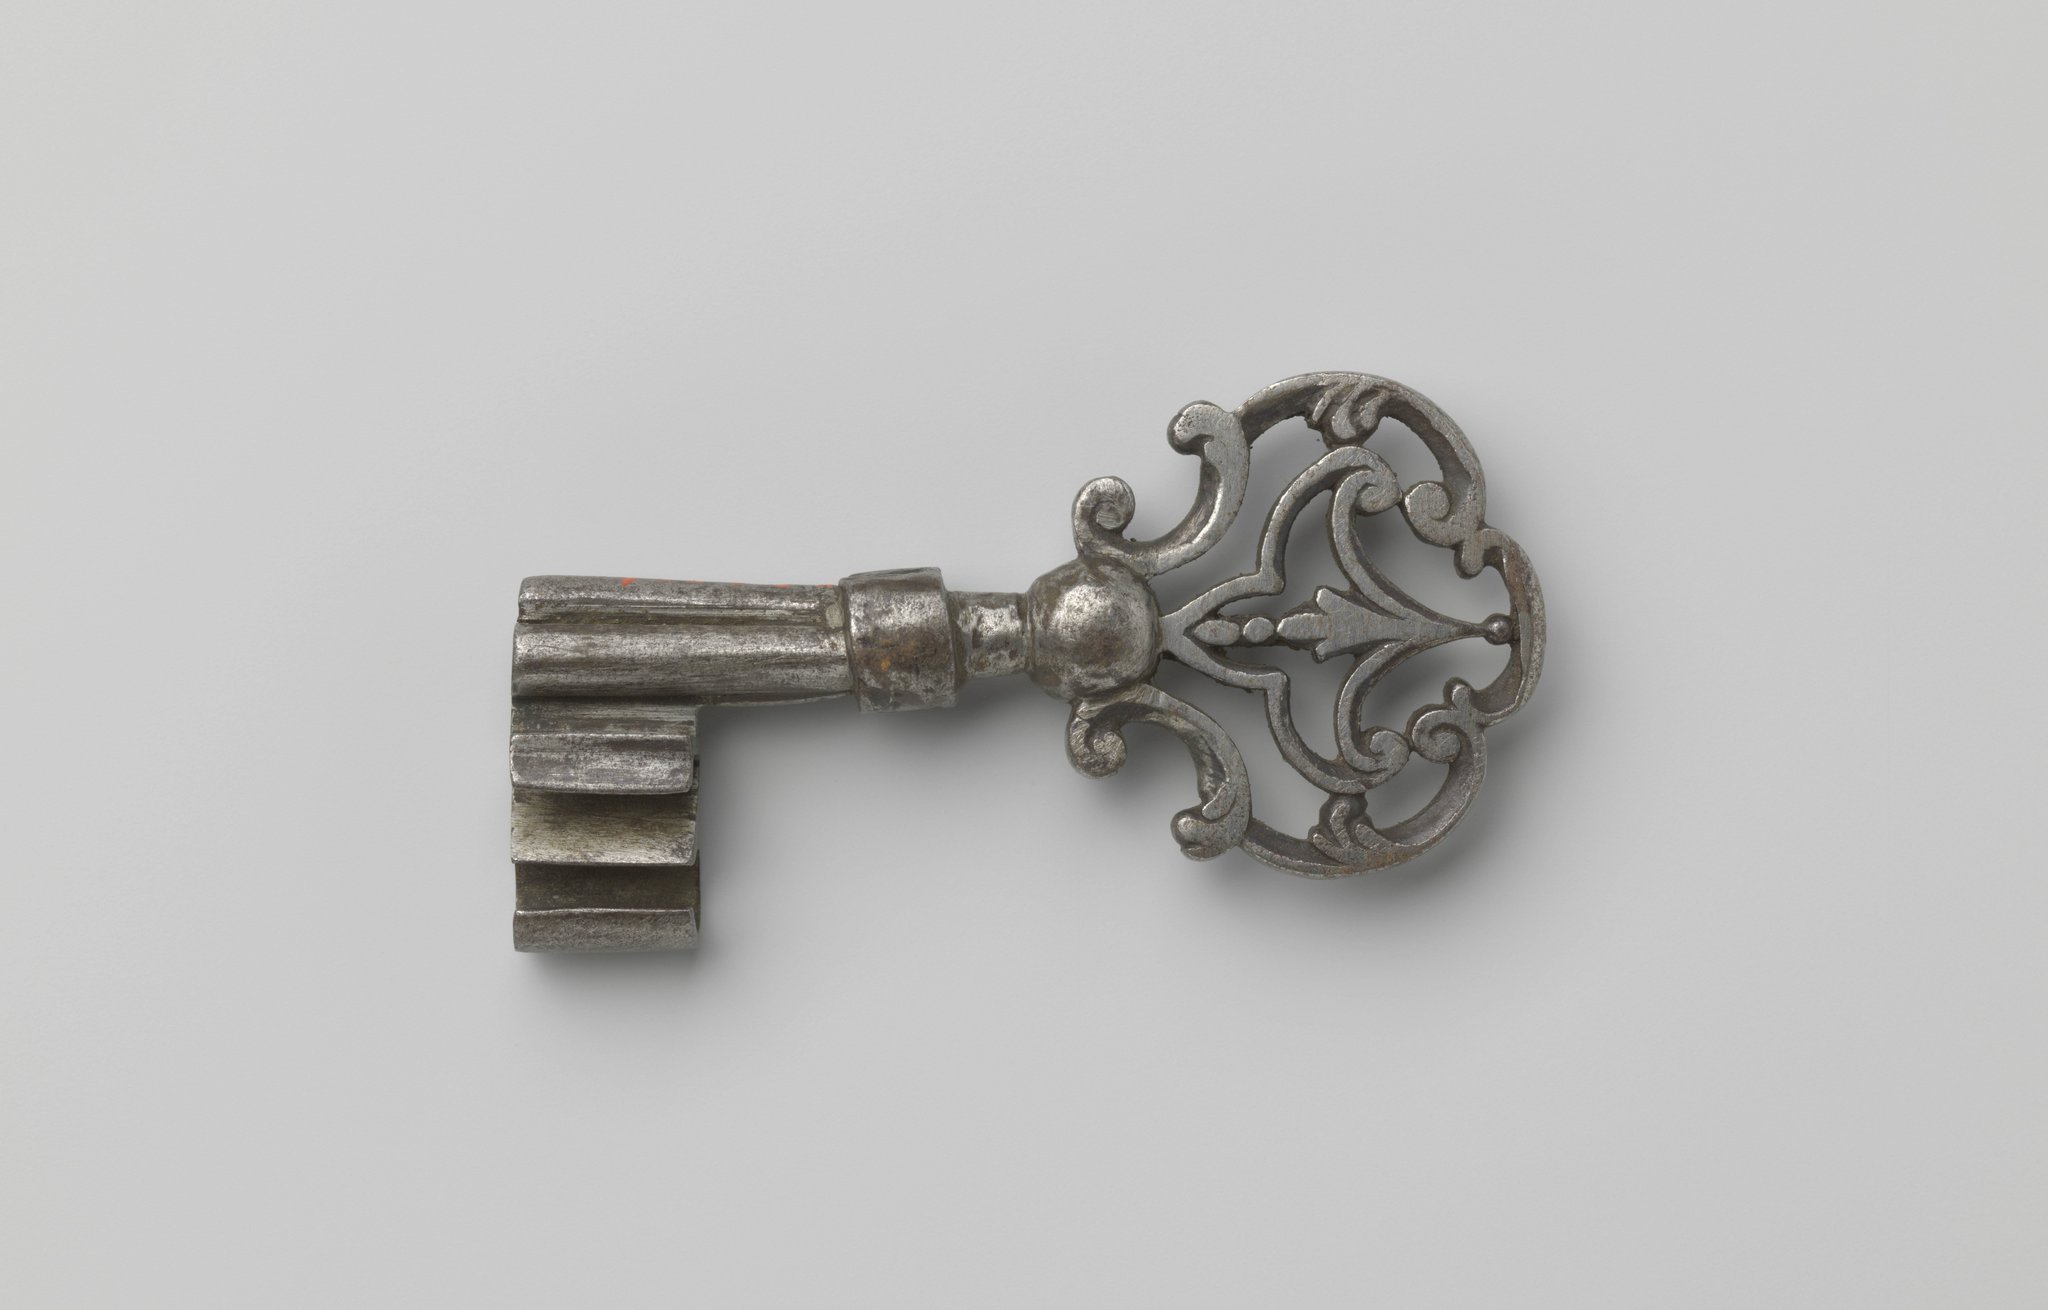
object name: key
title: Sleutel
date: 1400-1950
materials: iron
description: Sleutel met greep bestaande uit bladen S-voluten. Het kapiteel is kogelvormig en de sleutelborst een ronde hoge schijf. Aan de klaverbladvormig geboorde korte schacht zit een S-vormige baard.